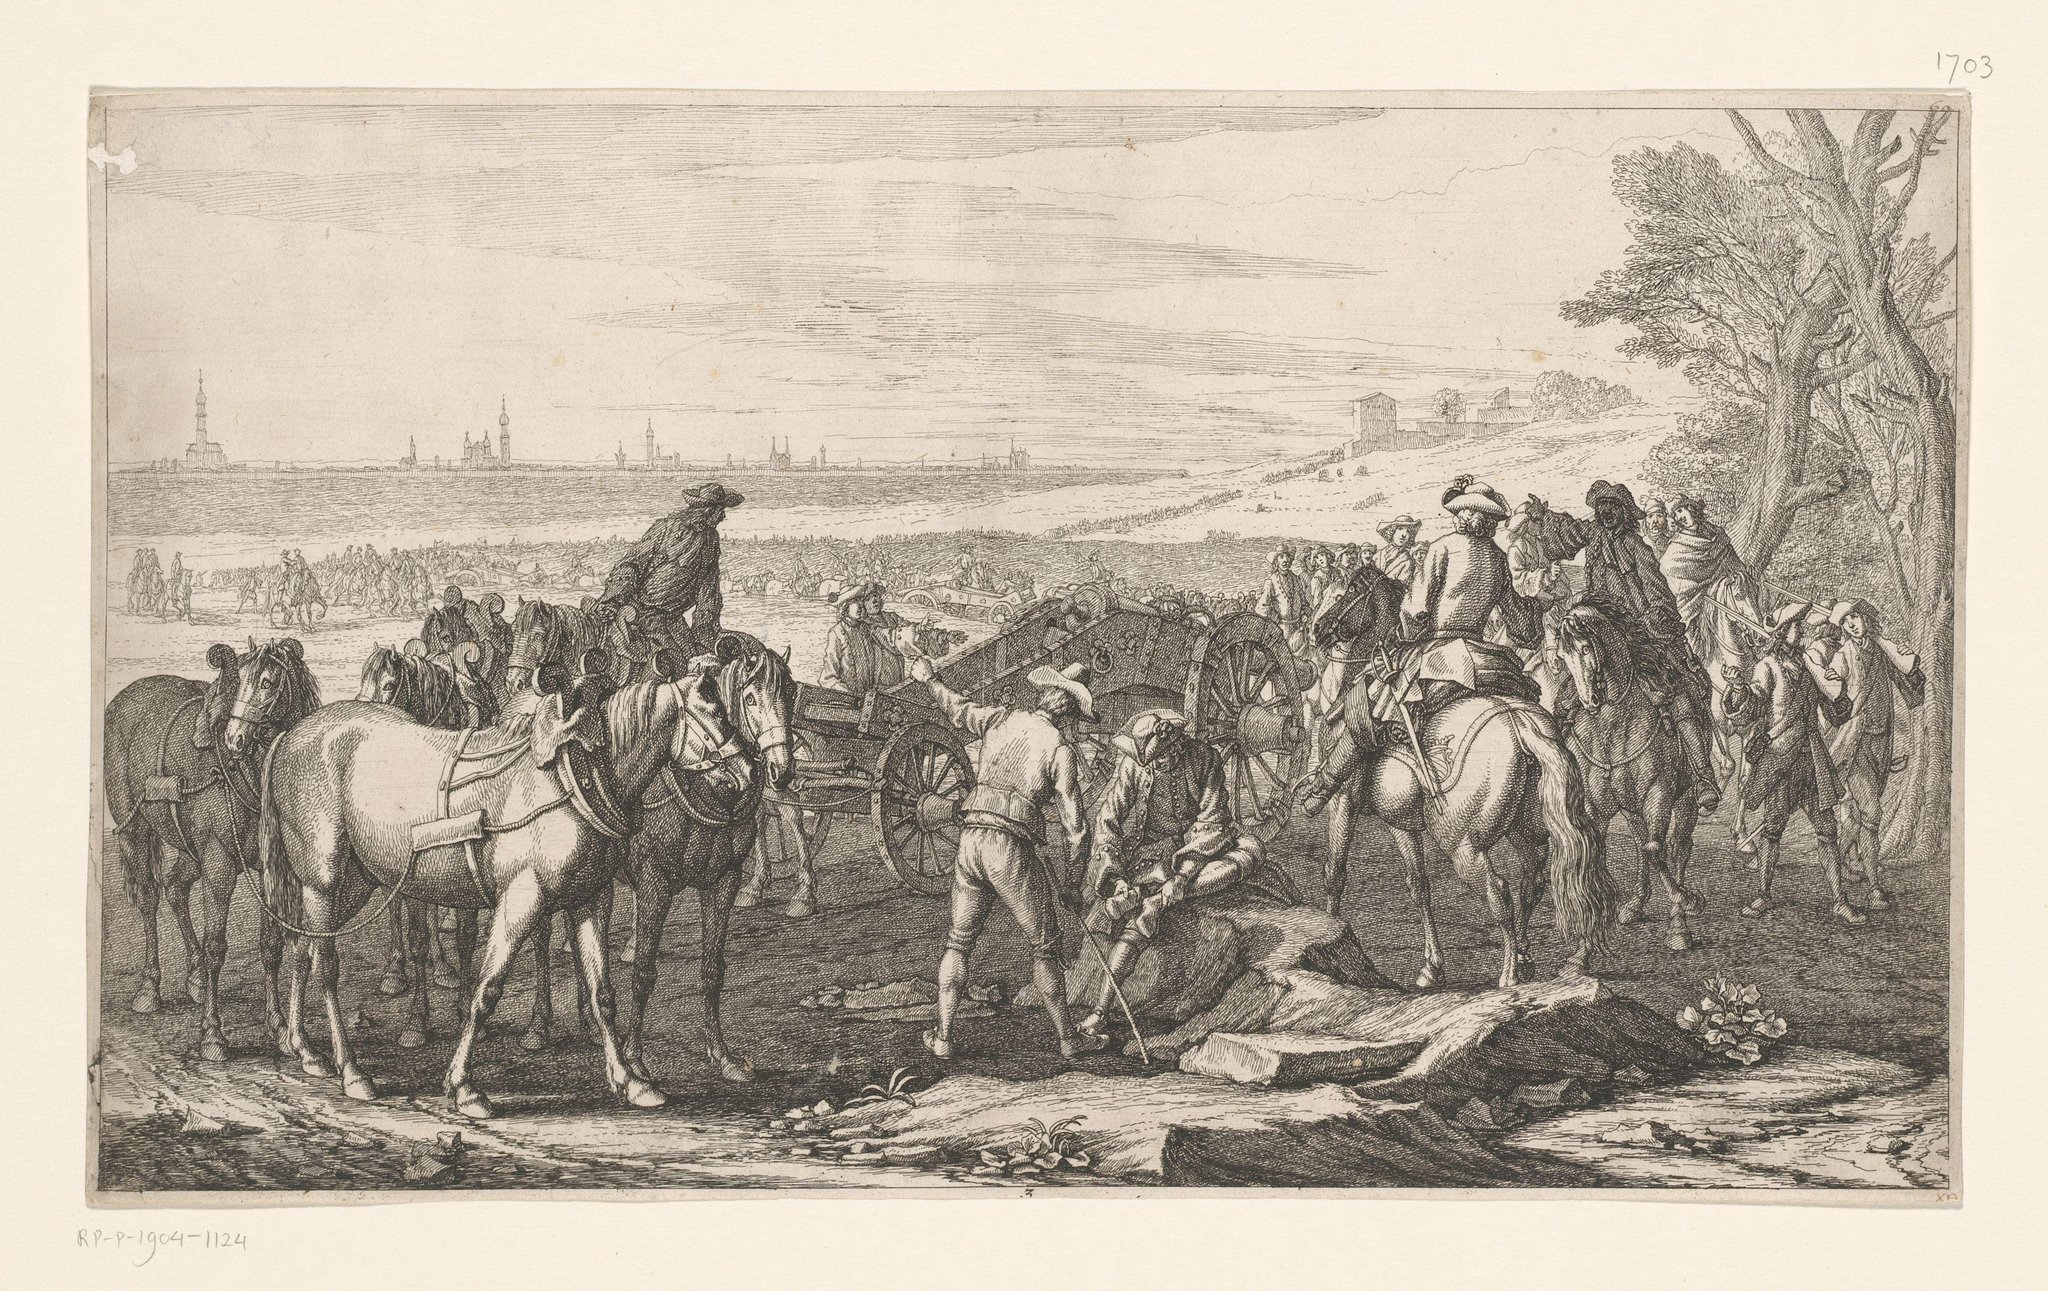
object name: print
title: Beleg van Augsburg, 1704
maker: georg philipp rugendas (i)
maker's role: draughtsman, print maker, publisher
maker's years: 1666-1742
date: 1705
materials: paper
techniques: etching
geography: augsburg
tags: transport, train (military) (+ land forces), siege, augsburg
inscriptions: collector's mark: Lugt 2228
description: Scène uit het beleg van Augsburg door de Fransen en Beiersen. Transport in januari 1704 van wapens en geschut uit Augsburg naar München. Links een kanon getrokken door zes paarden, aan het begin van de stoet. Een zittende officier trekt een schoen aan. In de verte de stad. Deze prent onderaan genummerd 3.